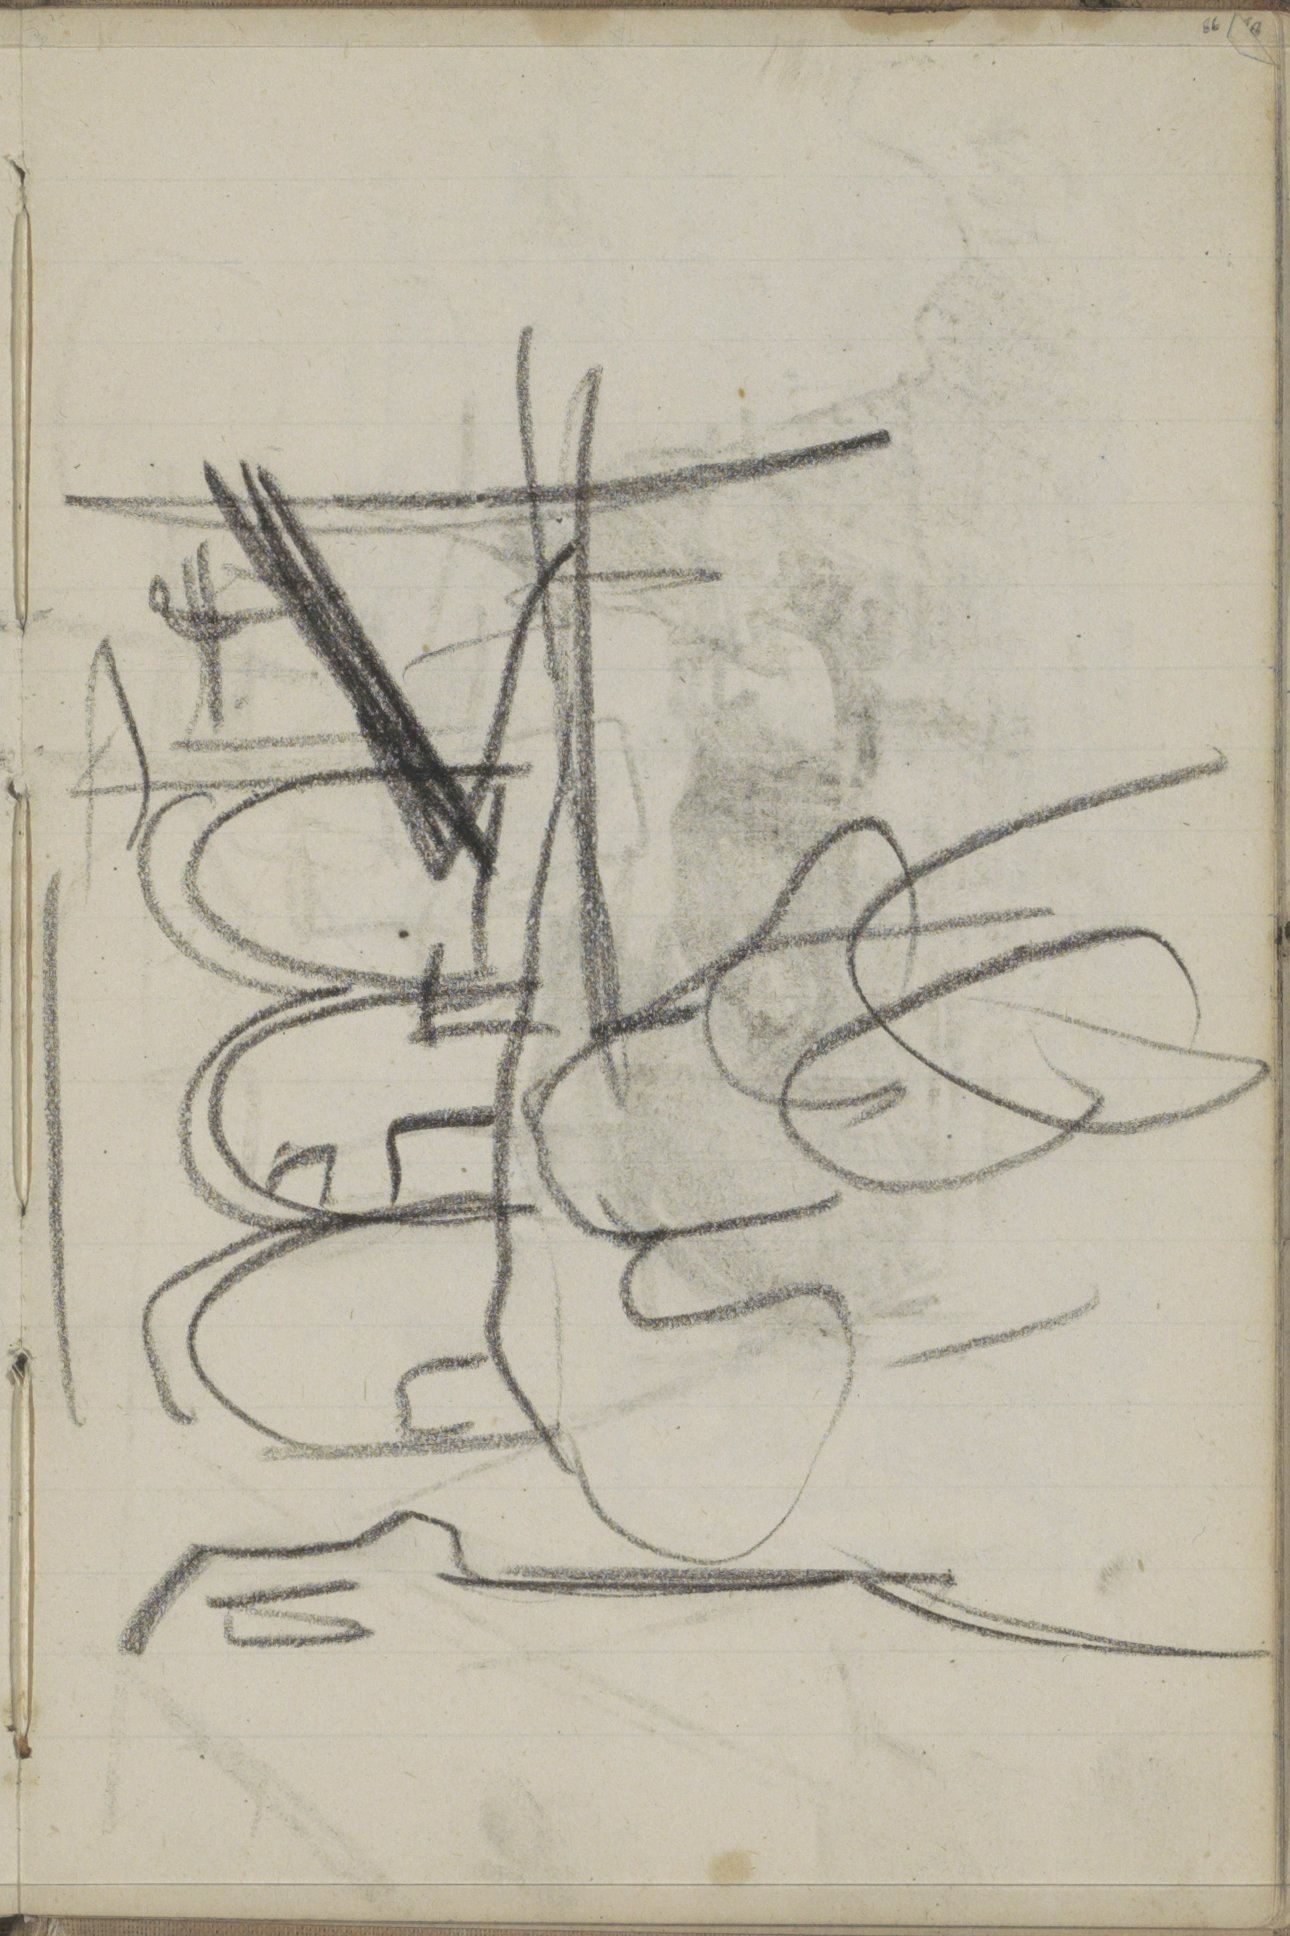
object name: sketchbook leaf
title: Arcade met rondbogen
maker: marius bauer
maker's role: draughtsman, print maker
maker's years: 1867-1932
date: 1888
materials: chalk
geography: istanbul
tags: arcade ~ architecture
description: Pagina 86 uit een schetsboek met 58 bladen.